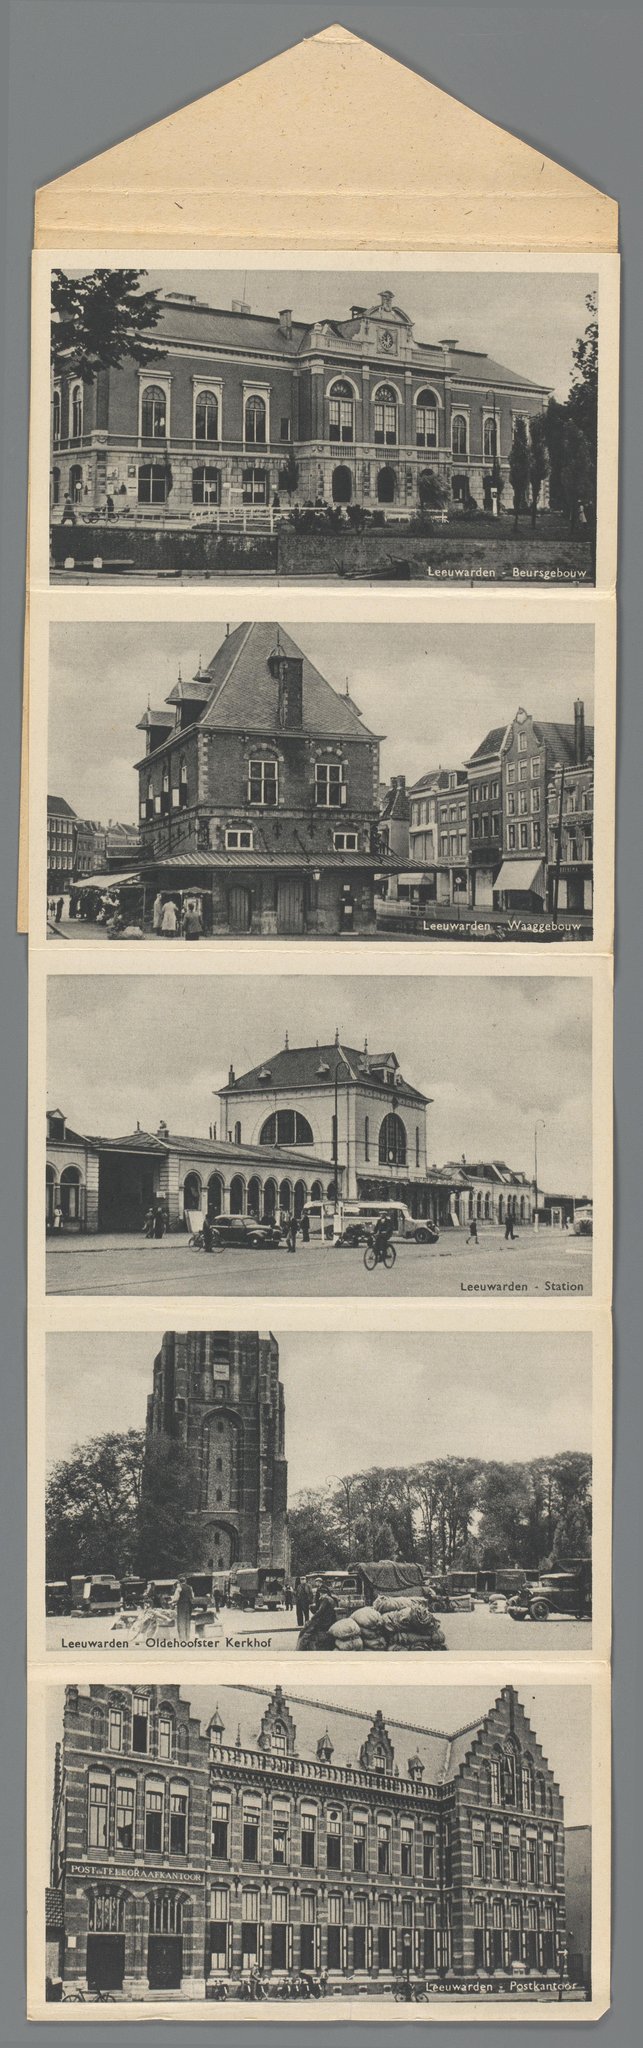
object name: accordion book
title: Leporelloalbum met vijf fotomechanische afdrukken van stadsgezichten van Leeuwarden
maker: Anonymous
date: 1920-1940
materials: cardboard, paper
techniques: rotogravure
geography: leeuwarden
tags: street